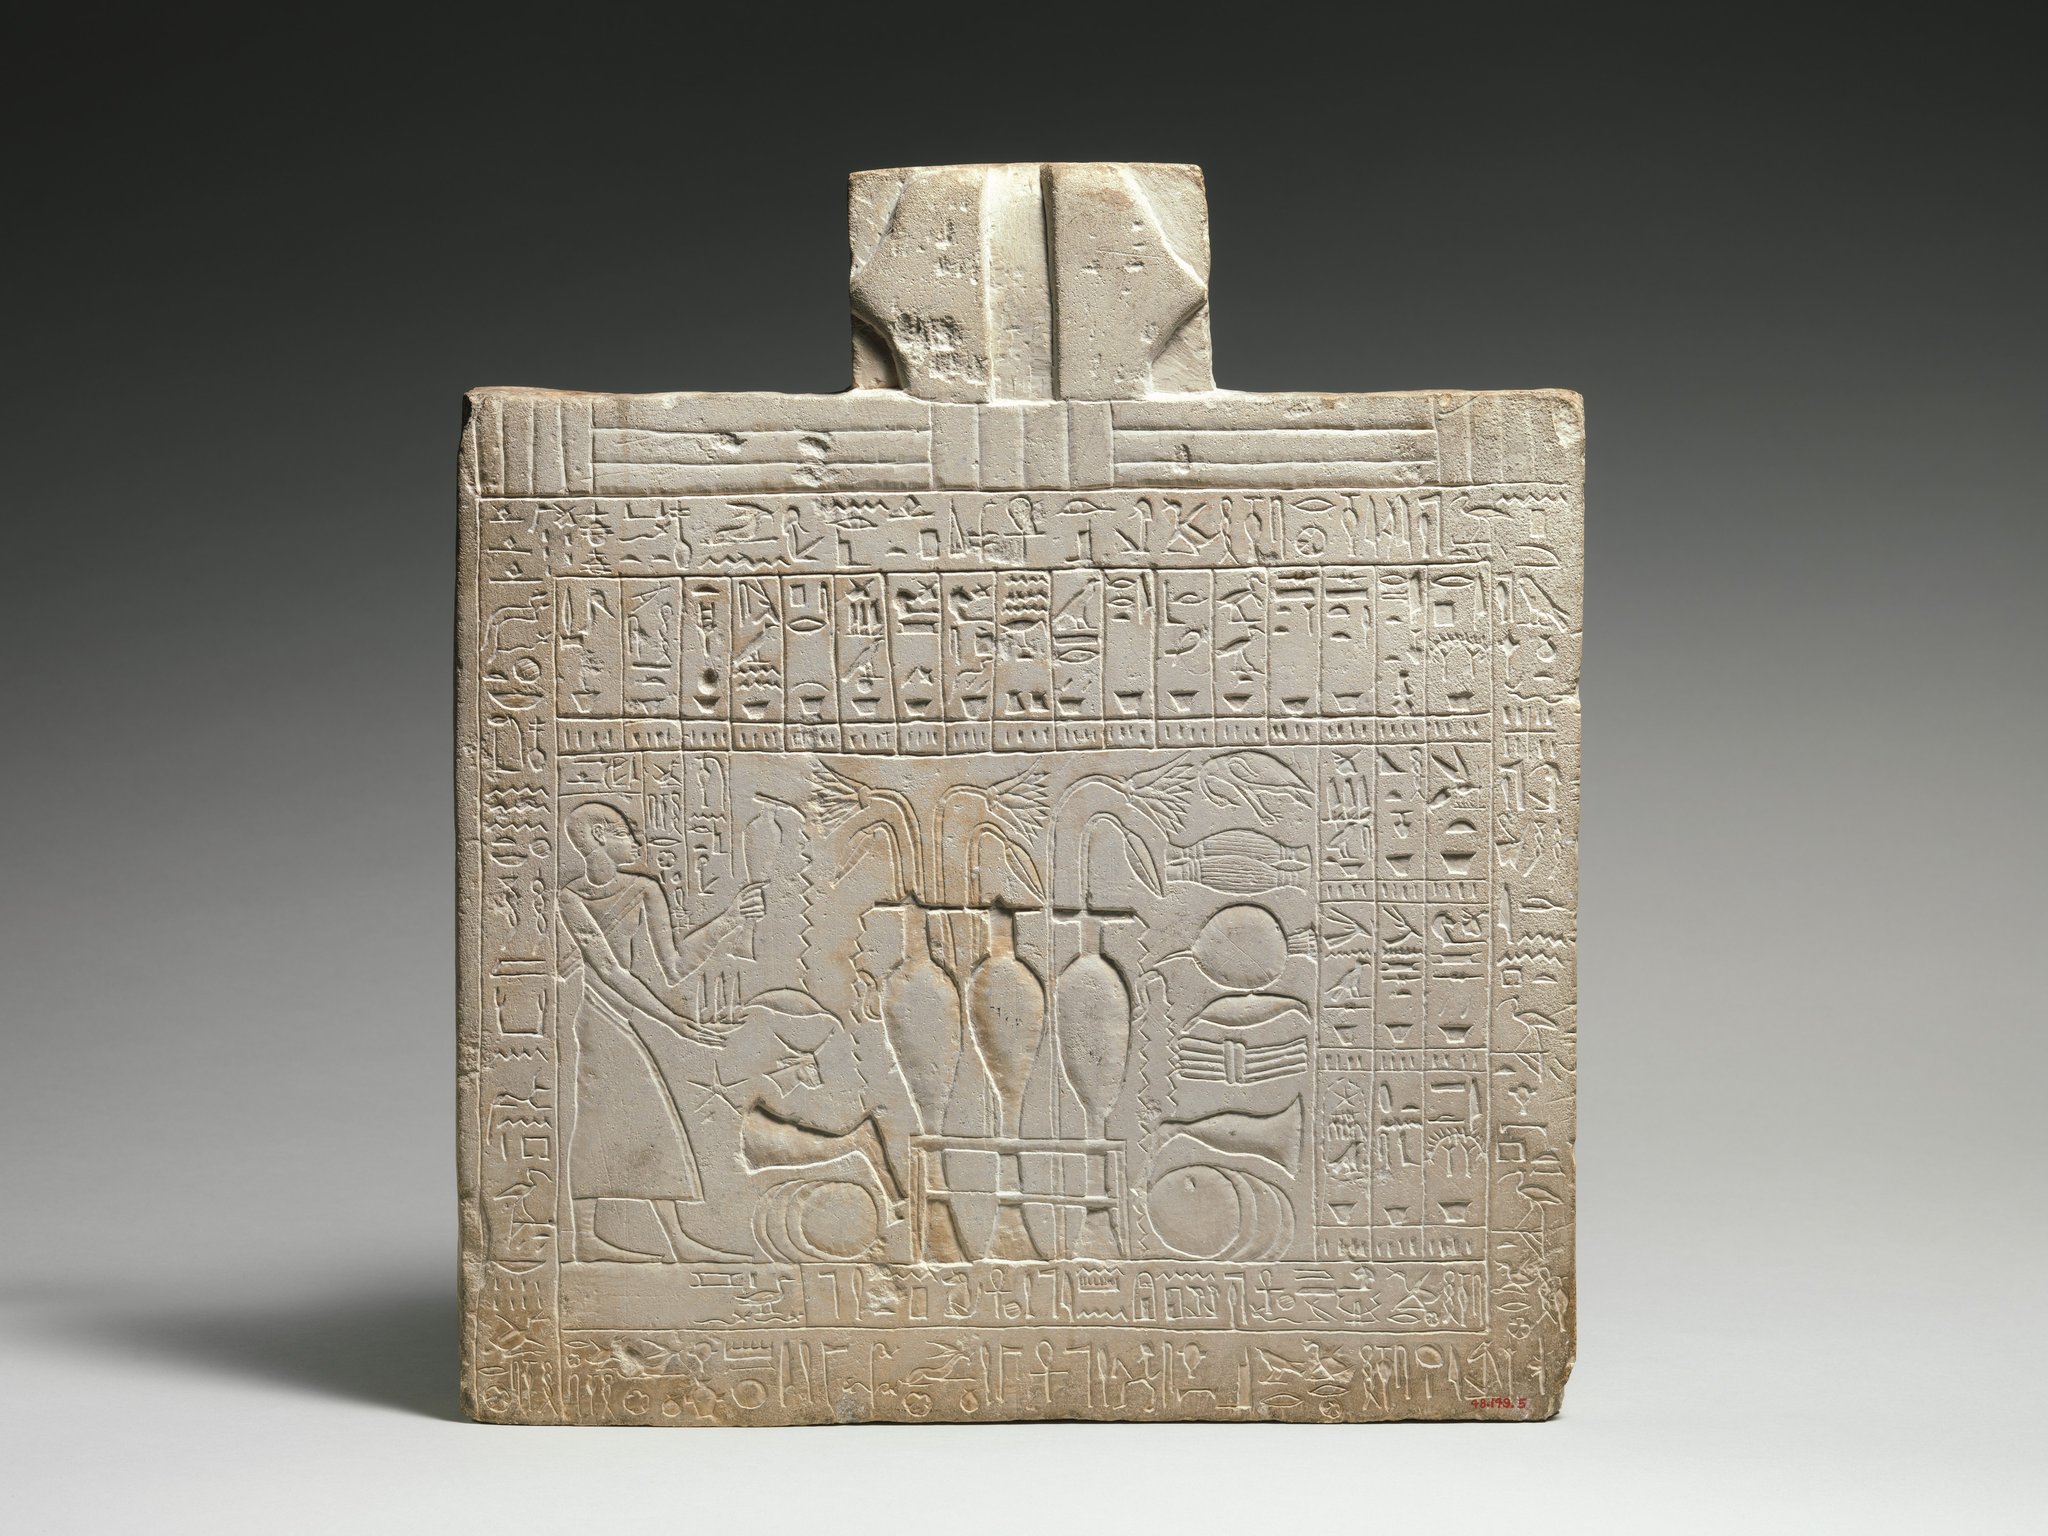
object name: offering table, tjaenhesret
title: Offering Table of Tjaenhesret, priest of Thoth, son of Iaa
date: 332-330 BCE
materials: limestone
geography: middle egypt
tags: men,hieroglyphs